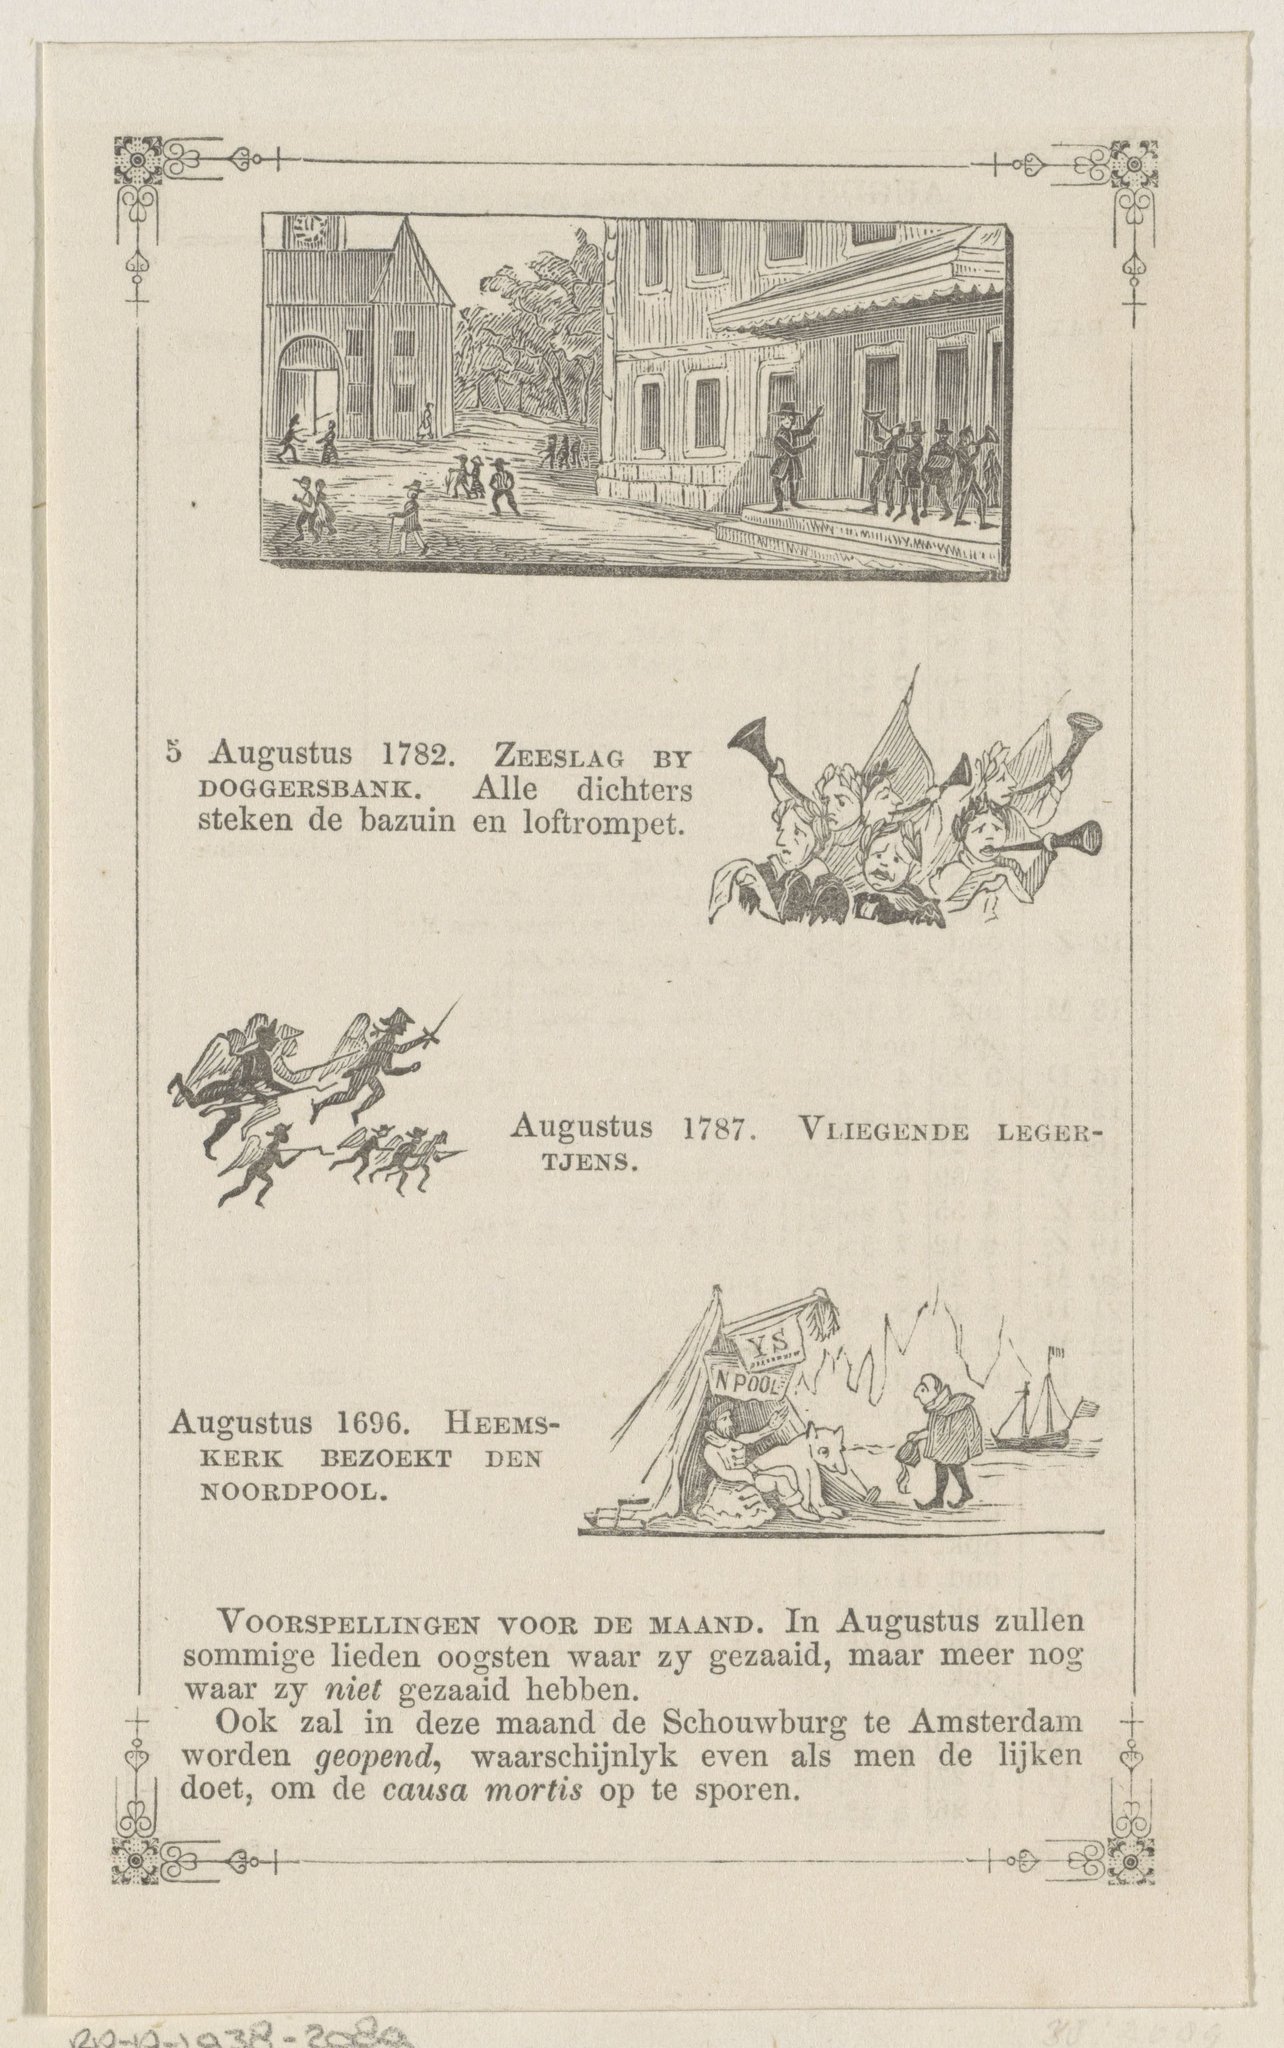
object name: book illustration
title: Augustus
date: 1849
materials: paper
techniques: letterpress printing, engraving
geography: netherlands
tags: zeeslag bij doggersbank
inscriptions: collector's mark: Lugt 2760, collector's mark: Lugt 2228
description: Midden boven een voorstelling van figuren musicerend op een podium. Daaronder een aantal voorstellingen van gebeurtenissen die plaatsvonden in de maand augustus, waaronder de Zeeslag bij Doggersbank in 1782. Midden onder voorspellingen voor de maand augustus in 1849.